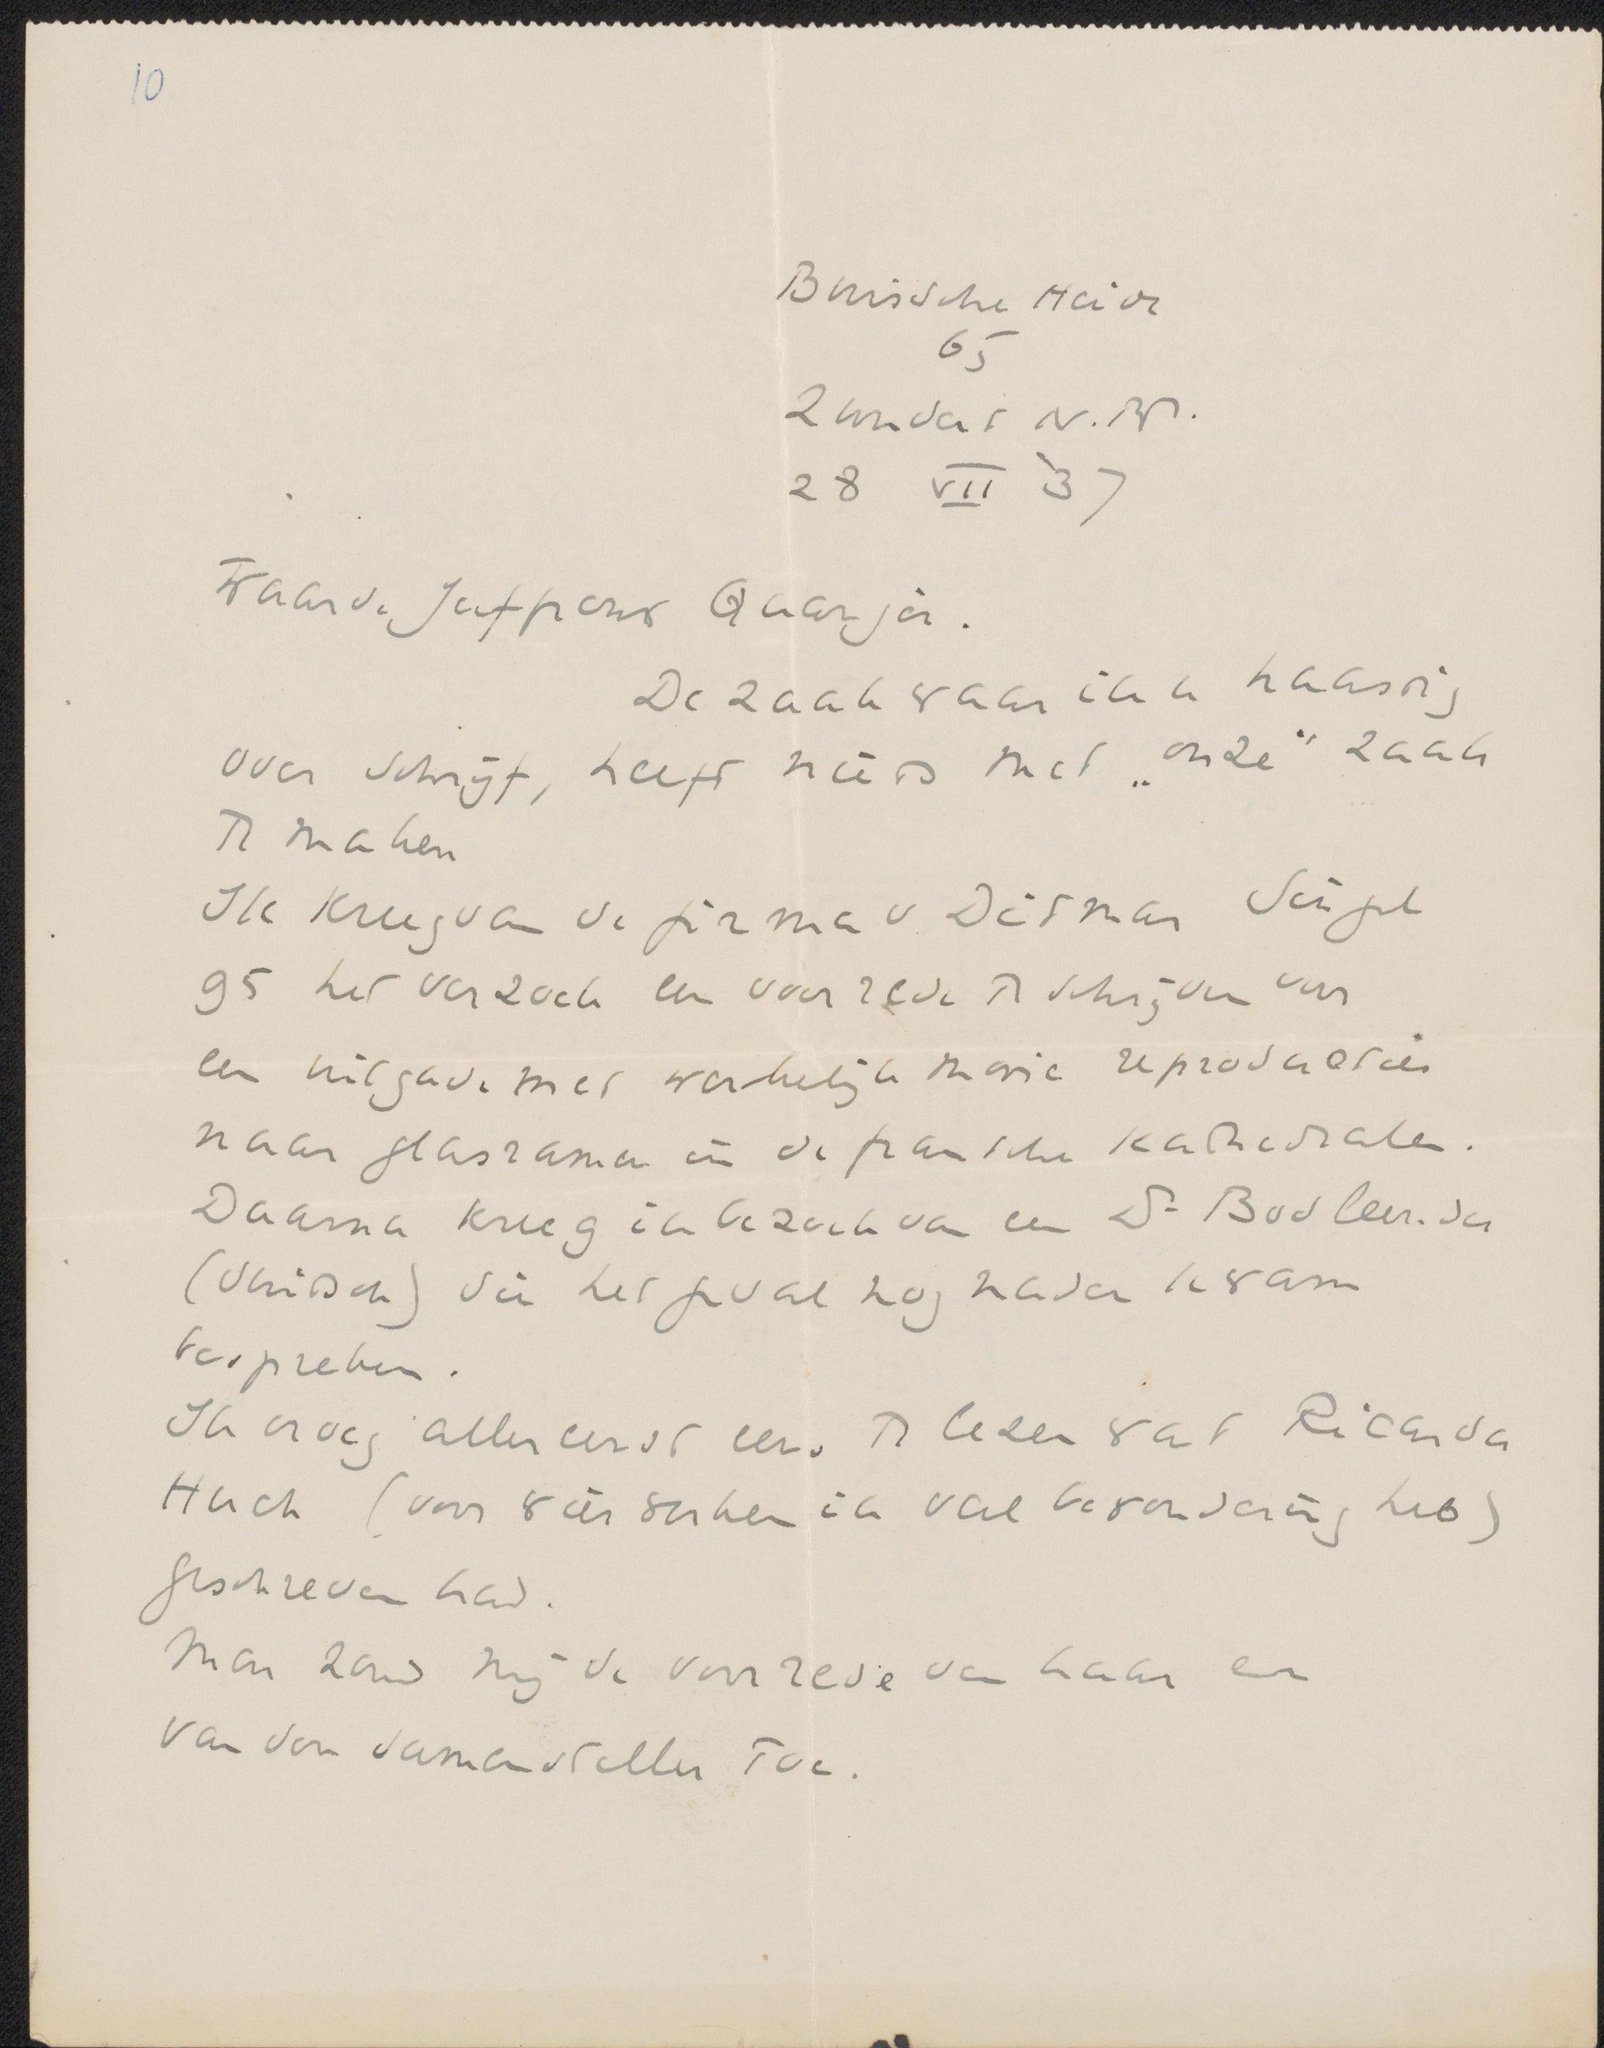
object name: letter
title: Brief aan Marisa Quanjer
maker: richard nicolaüs roland holst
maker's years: 1868-1938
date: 1937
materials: ink, paper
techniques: pen, writing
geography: zundert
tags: ferrand waley hudig, publisher, sculpture, money, printed matter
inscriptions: collector's mark: ‘RPK’